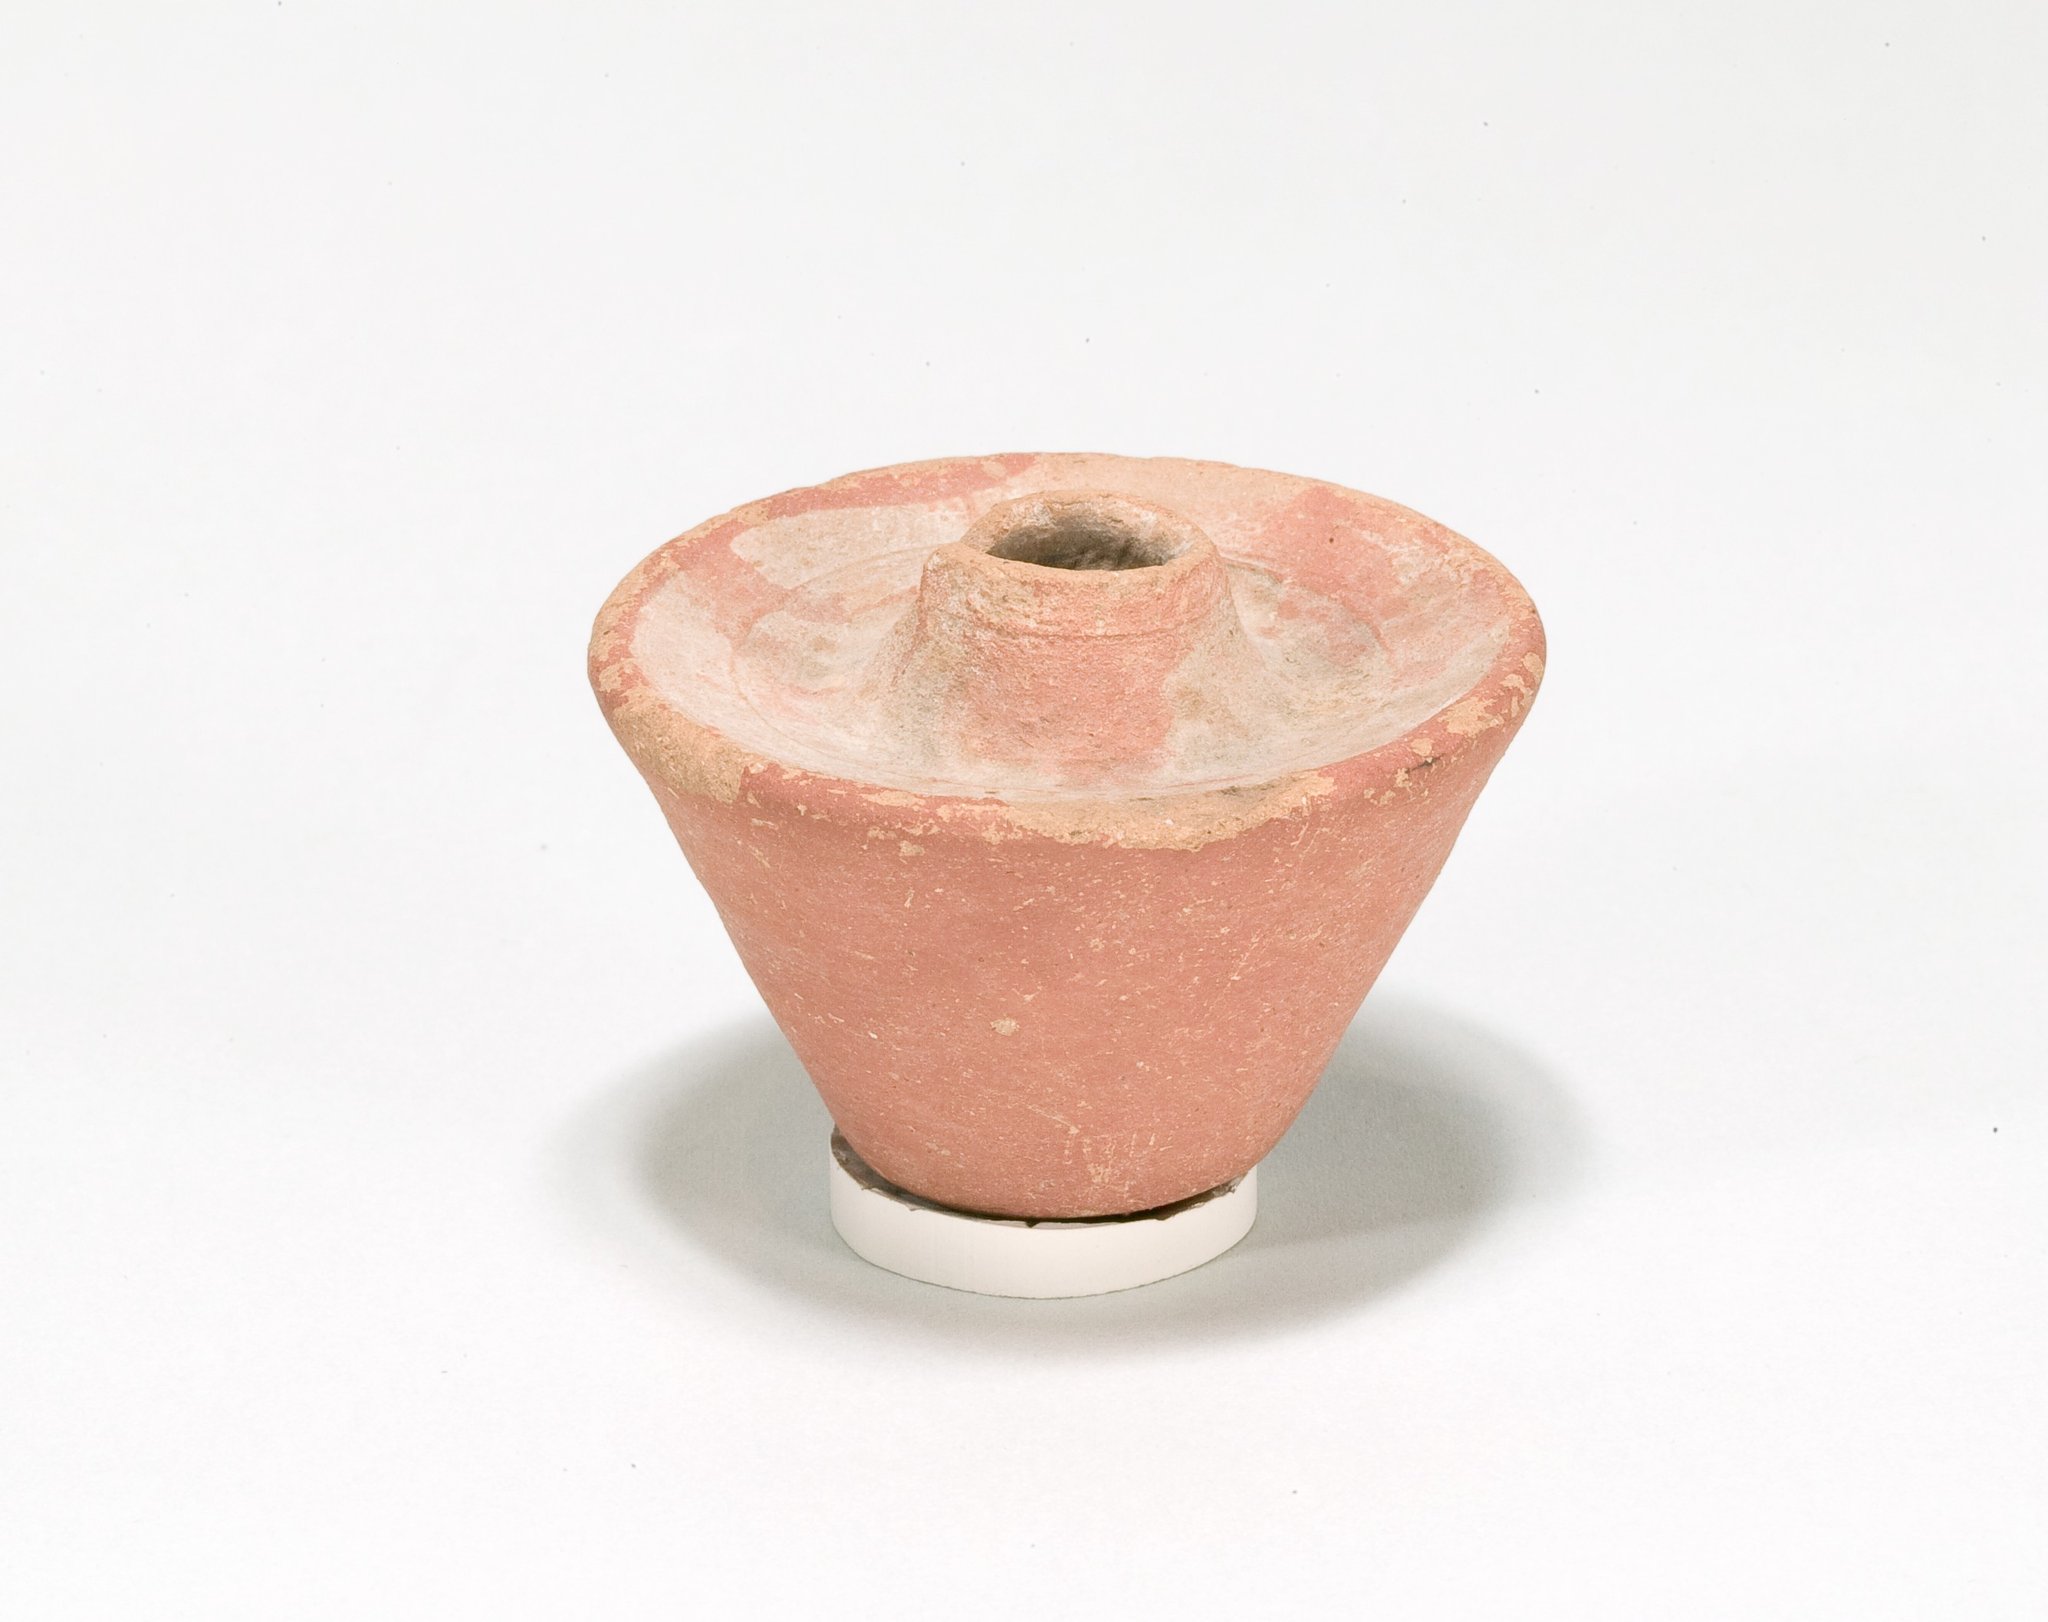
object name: lamp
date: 1981-1640 BCE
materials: pottery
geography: egypt